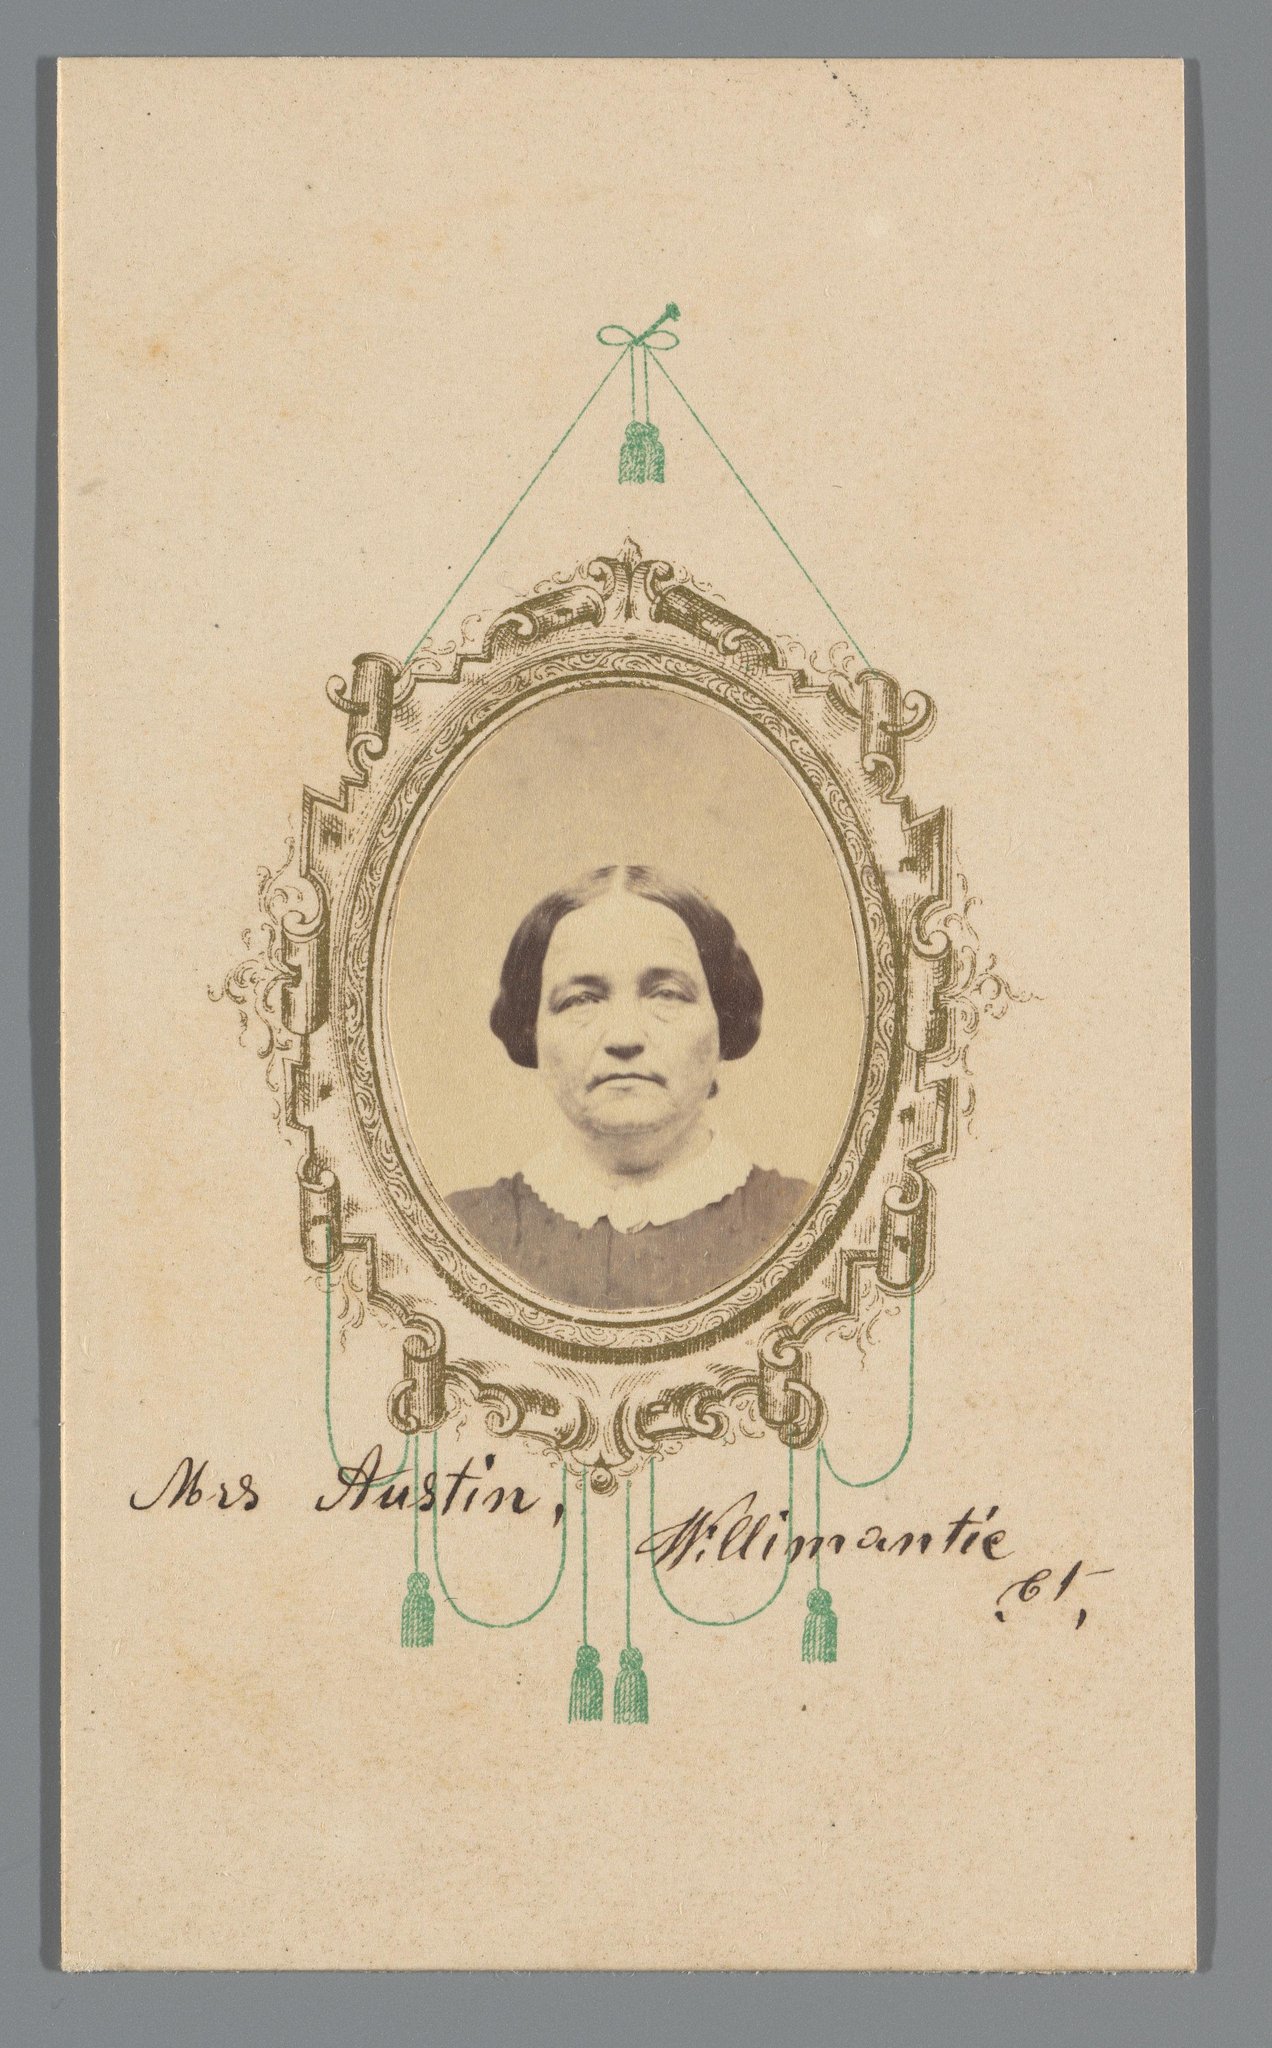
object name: carte de visite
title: Portret van Mrs. Austin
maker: mrs. h. royce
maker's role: fotograaf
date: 1860-1880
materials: photographic support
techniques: albumen print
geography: willimantic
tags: united states of america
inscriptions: inscription: ‘GEM PHOTOGRAPHS, / By MRS. H. ROYCE, / WILLIMANTIC, CT. / One Dollar per Dozen. / Additional copies of the Picture / may be had if wanted.’, inscription: ‘M G [of J] Howe’, inscription: ‘Mrs. Austin, Willimantic, CT’